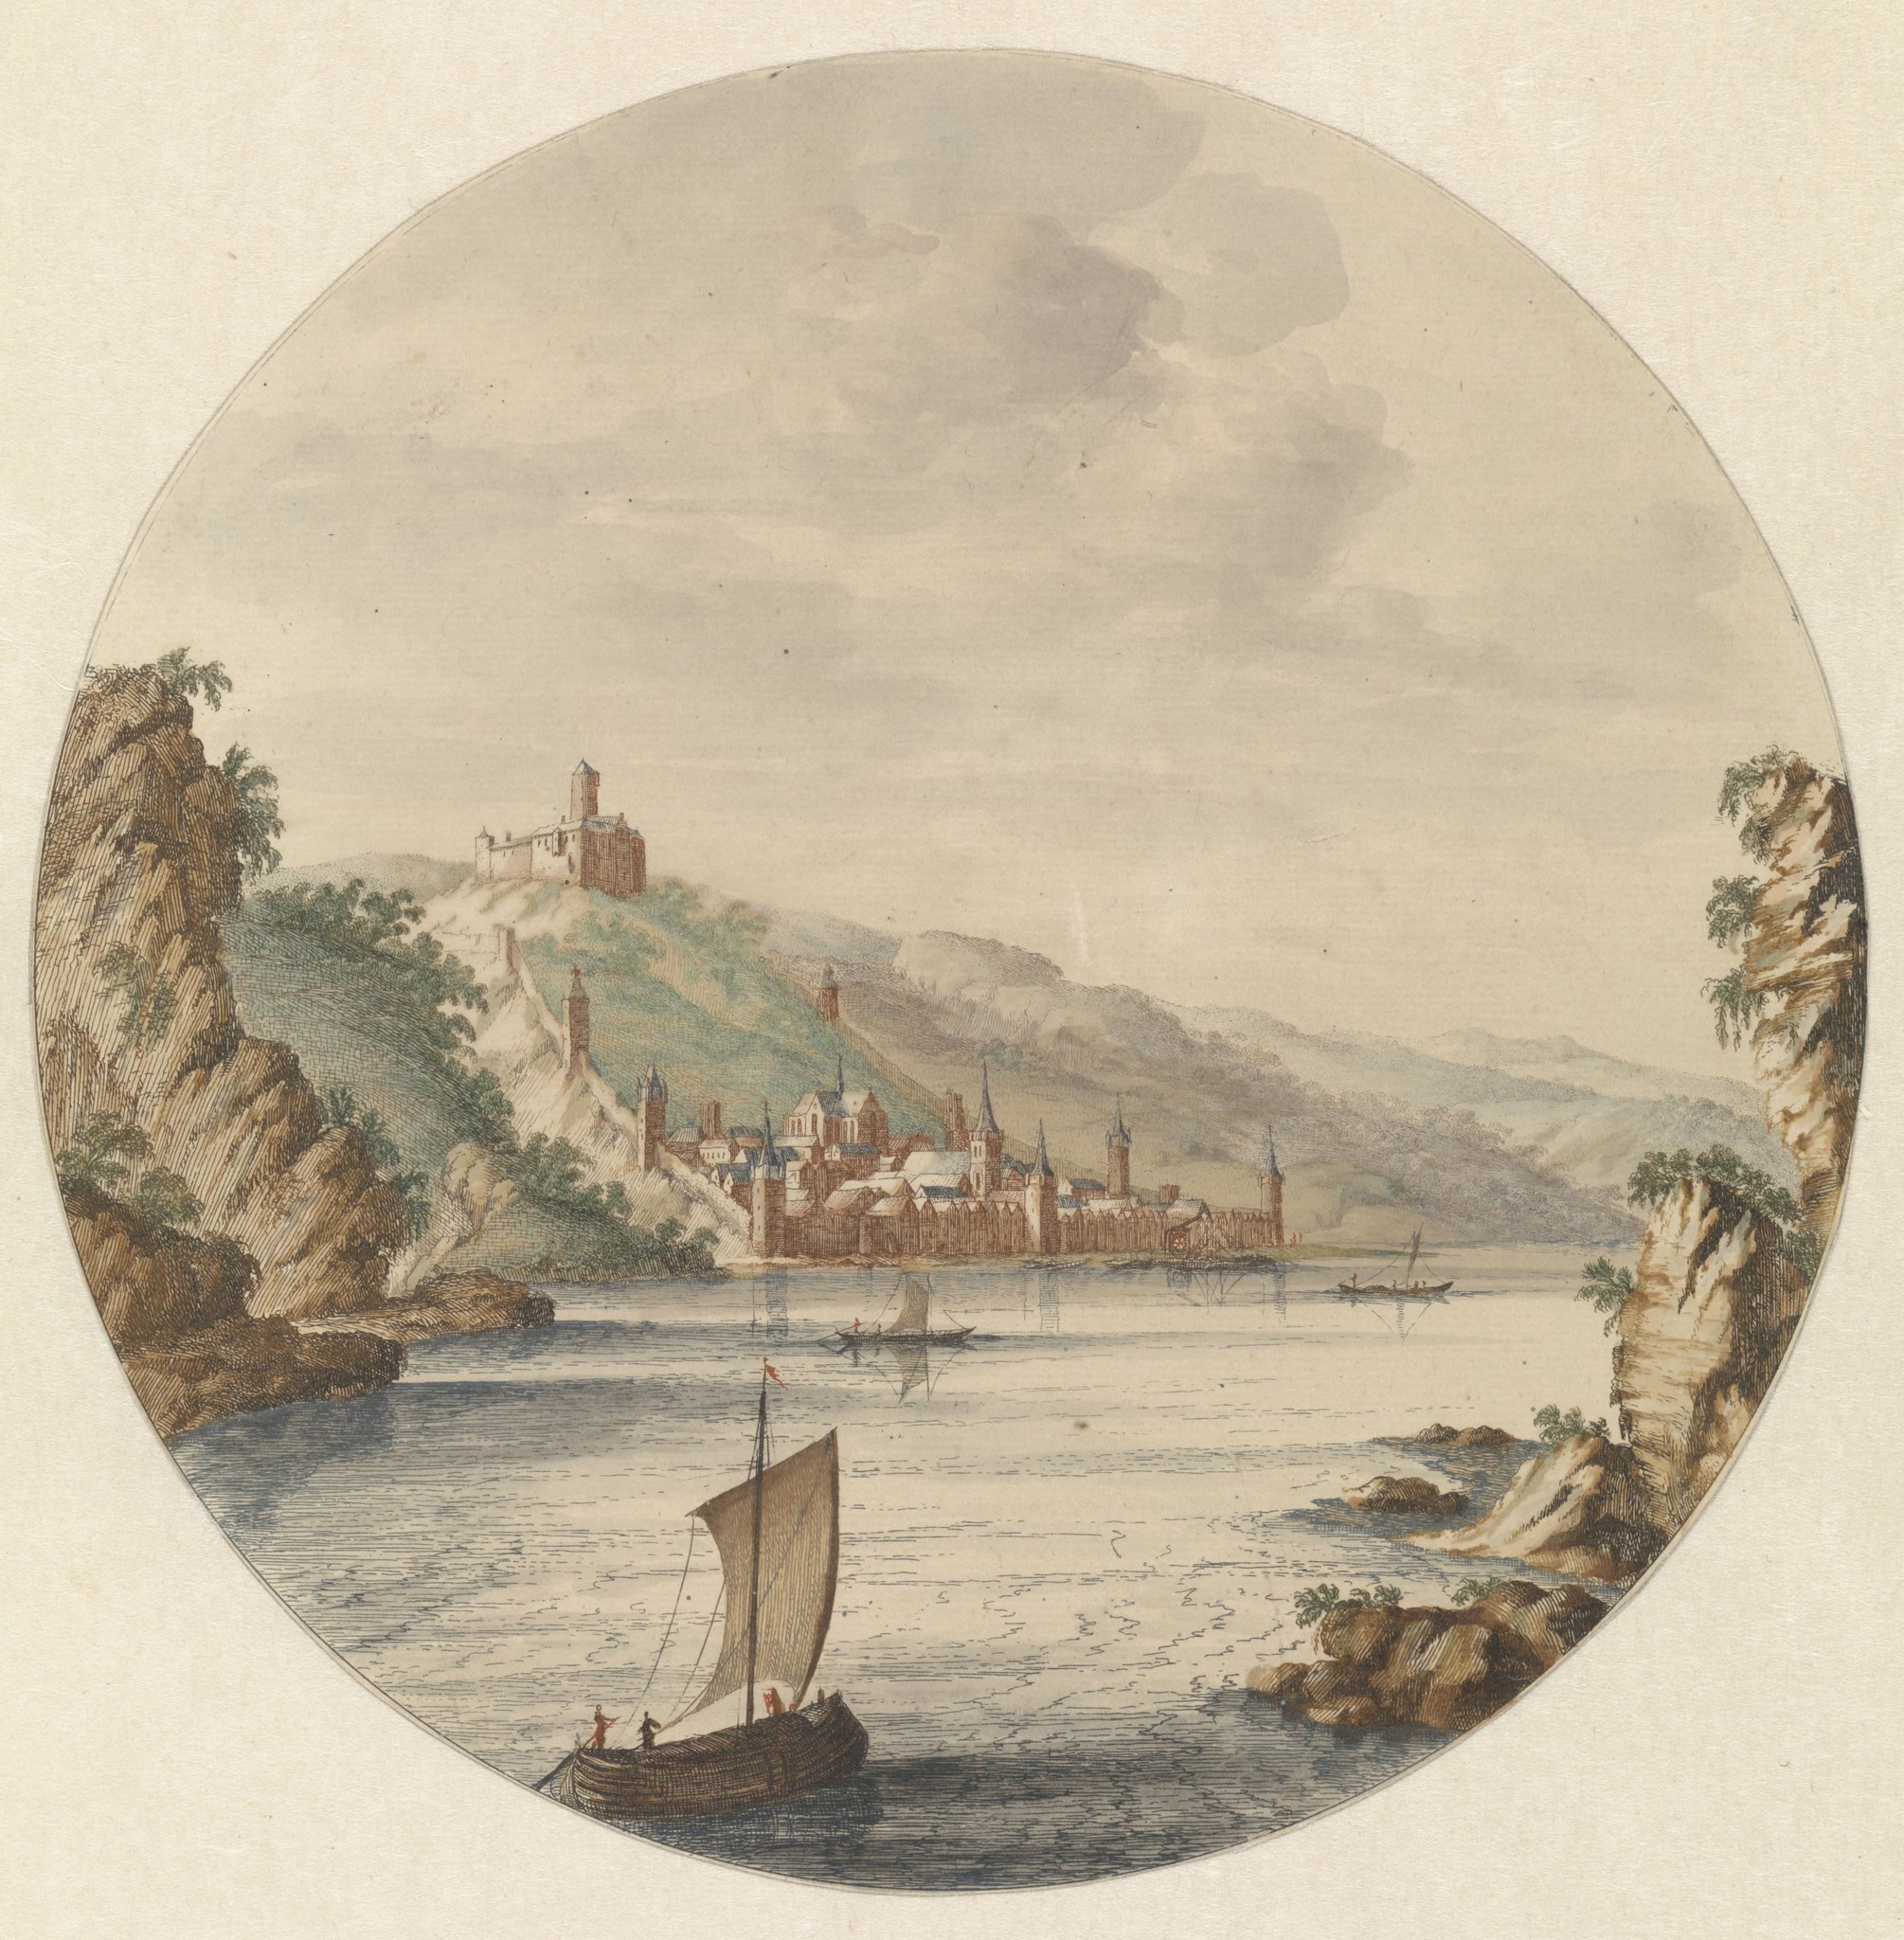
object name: print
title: Gezicht op de stad Bacharach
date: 1658-1712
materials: paper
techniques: etching, hand coloring, lithography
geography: netherlands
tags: fortress, city-view in general; 'veduta'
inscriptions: collector's mark: Lugt 2228, collector's mark: Lugt 2760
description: Gezicht op de stad Bacharach aan de Rijn. Op de heuvel de burcht Stahleck. Op de voorgrond een zeilschip.